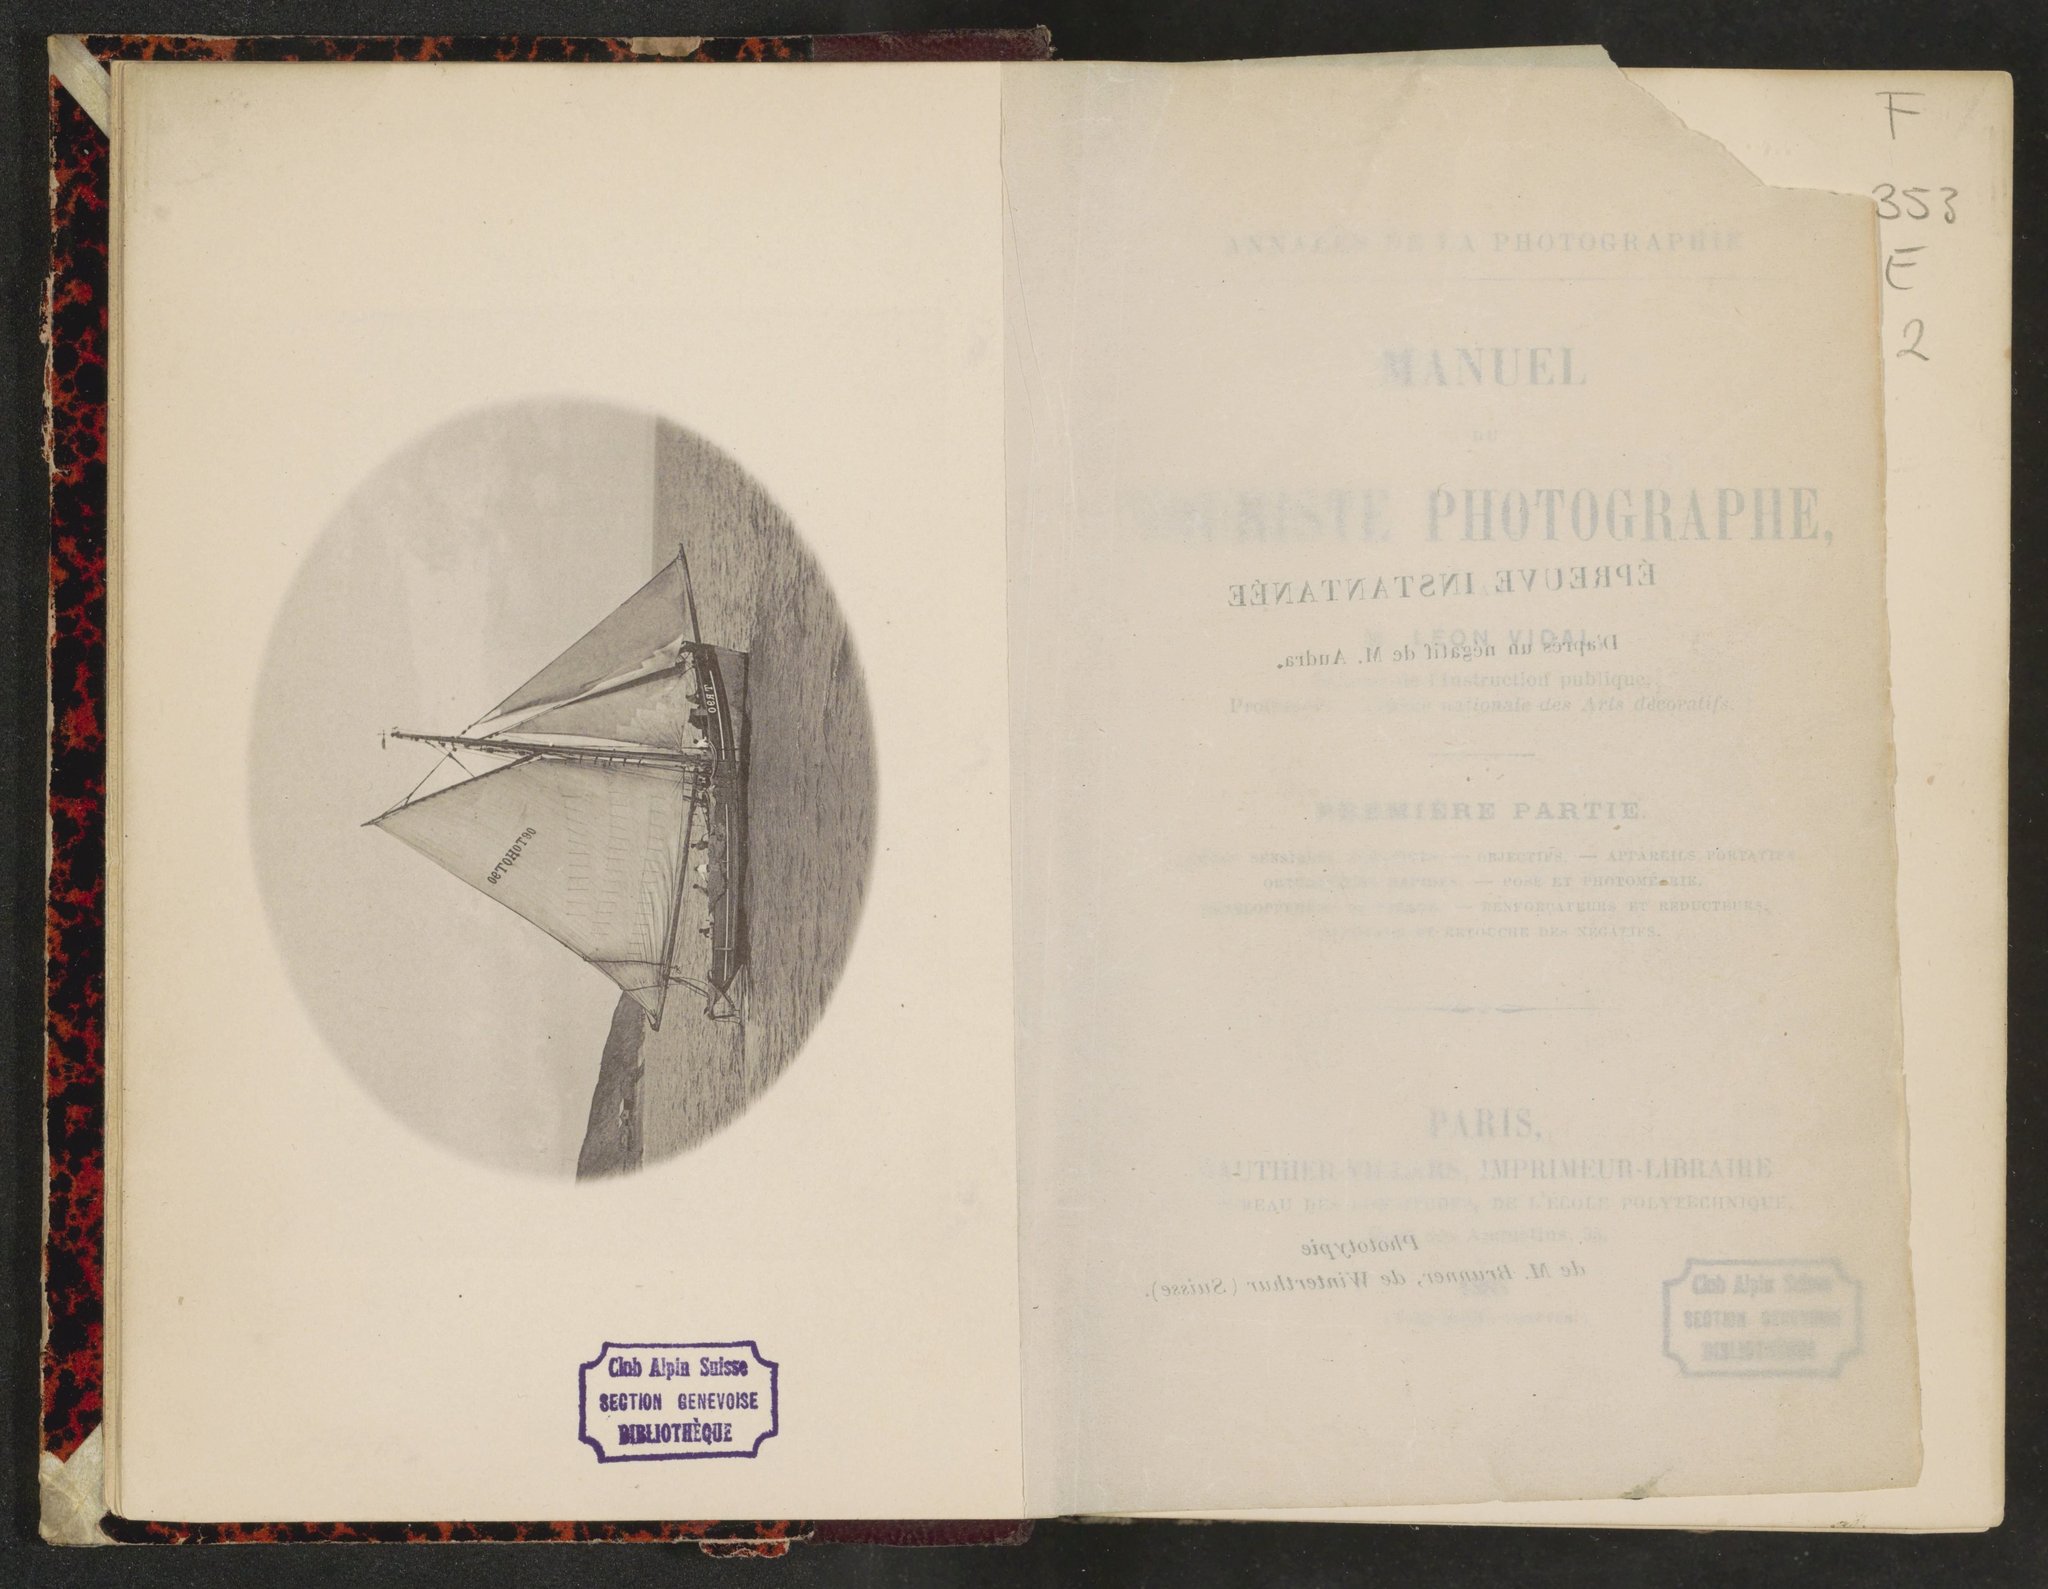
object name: photomechanical print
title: Épreuve instantée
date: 1875-1885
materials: paper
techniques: photograph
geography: winterthur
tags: sailing-ship, sailing-boat